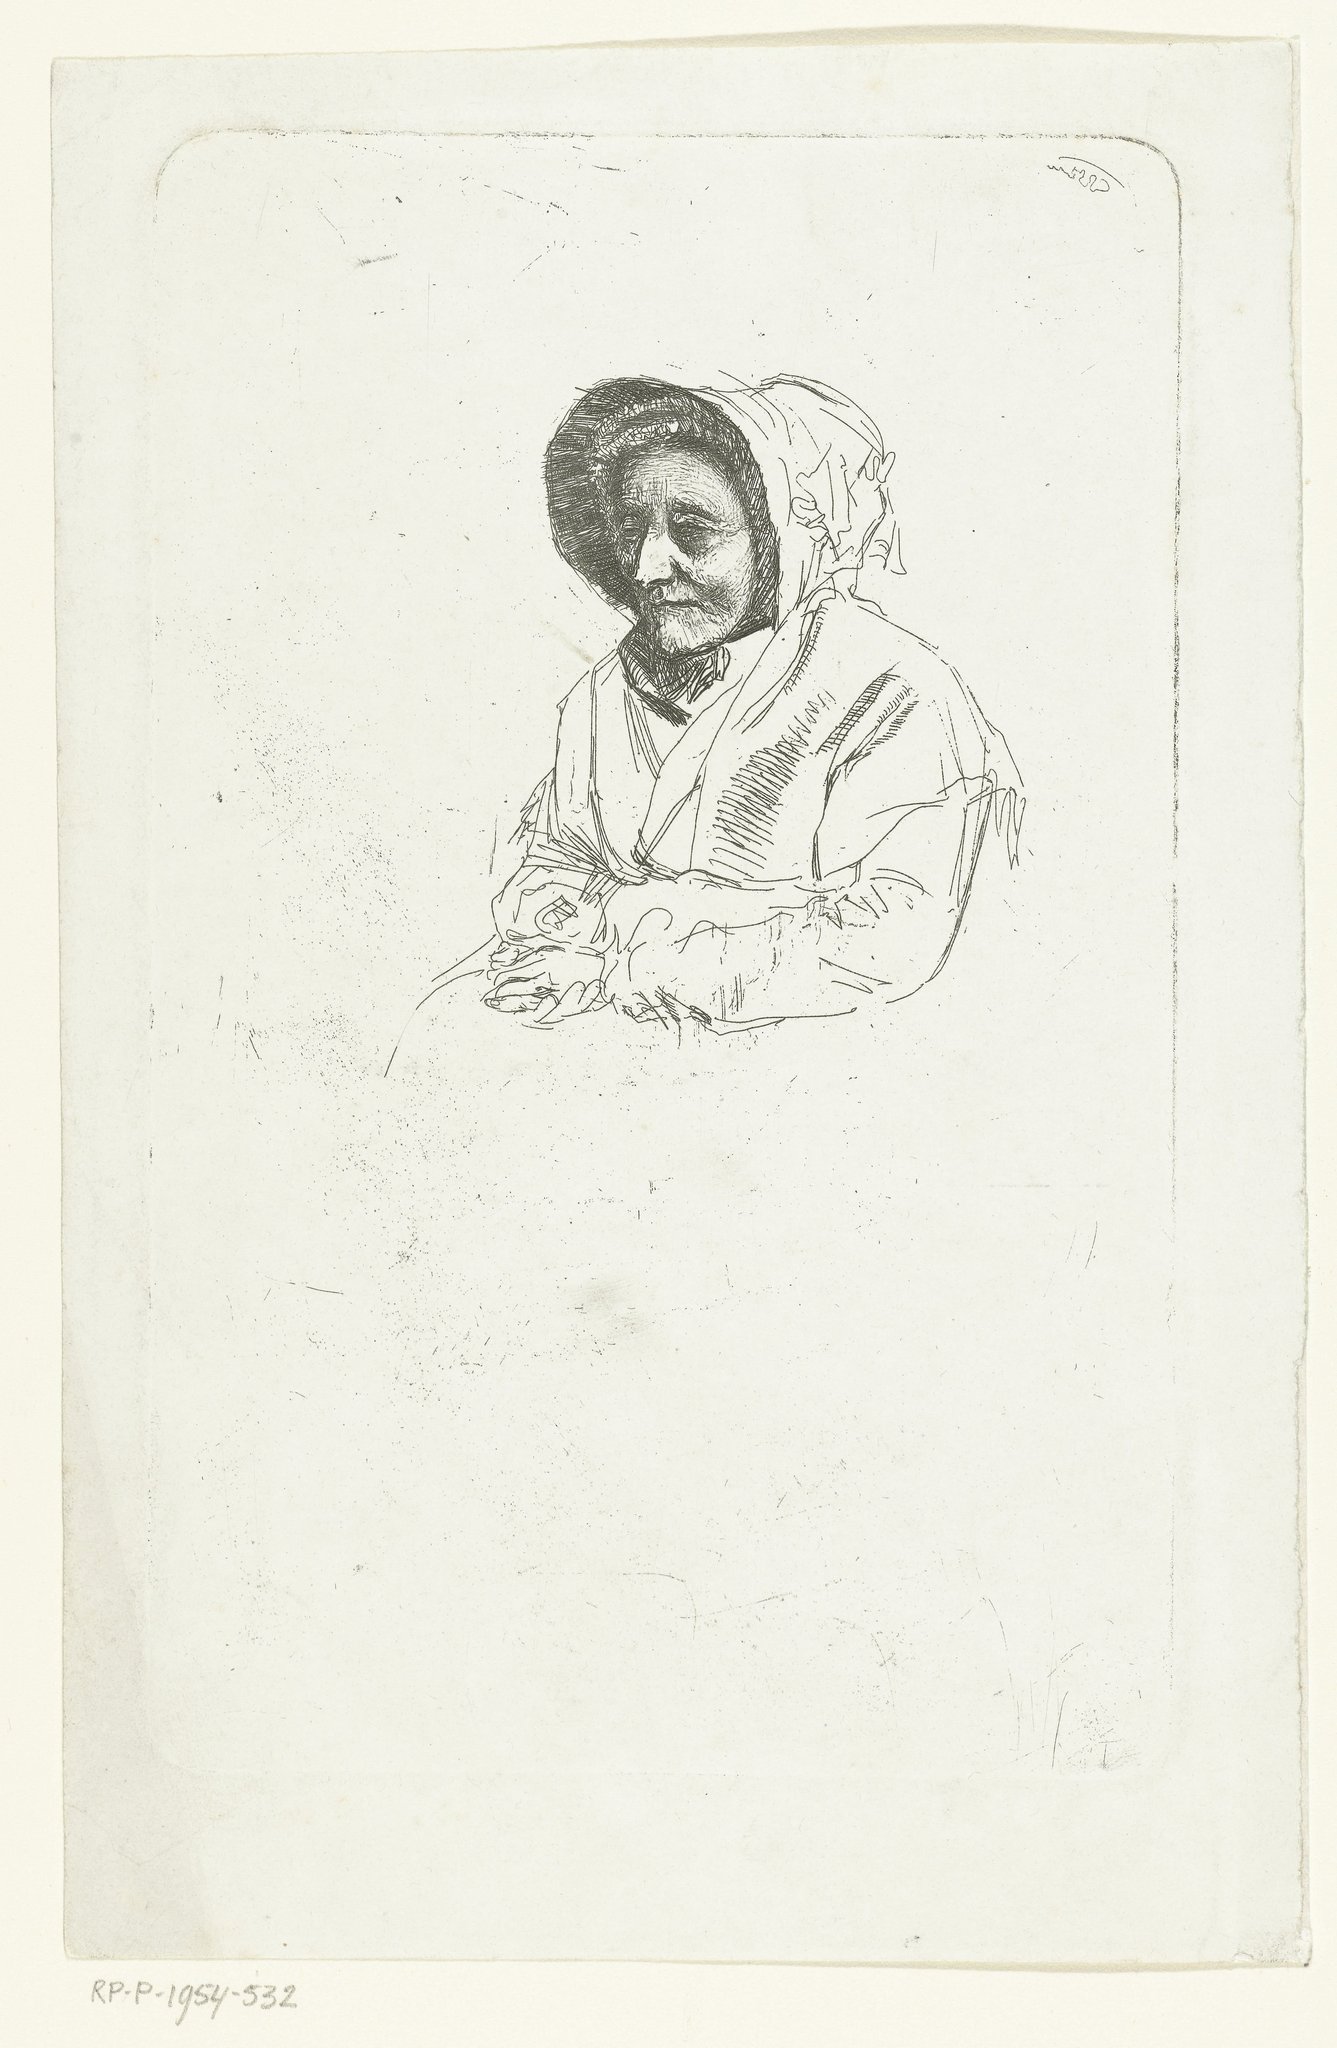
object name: print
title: Zittende oude dame met muts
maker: joan berg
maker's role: draughtsman, print maker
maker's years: 1851-1935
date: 1861-1935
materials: paper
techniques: etching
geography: netherlands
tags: head-gear, old woman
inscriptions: collector's mark: Lugt 2760, collector's mark: Lugt 2228